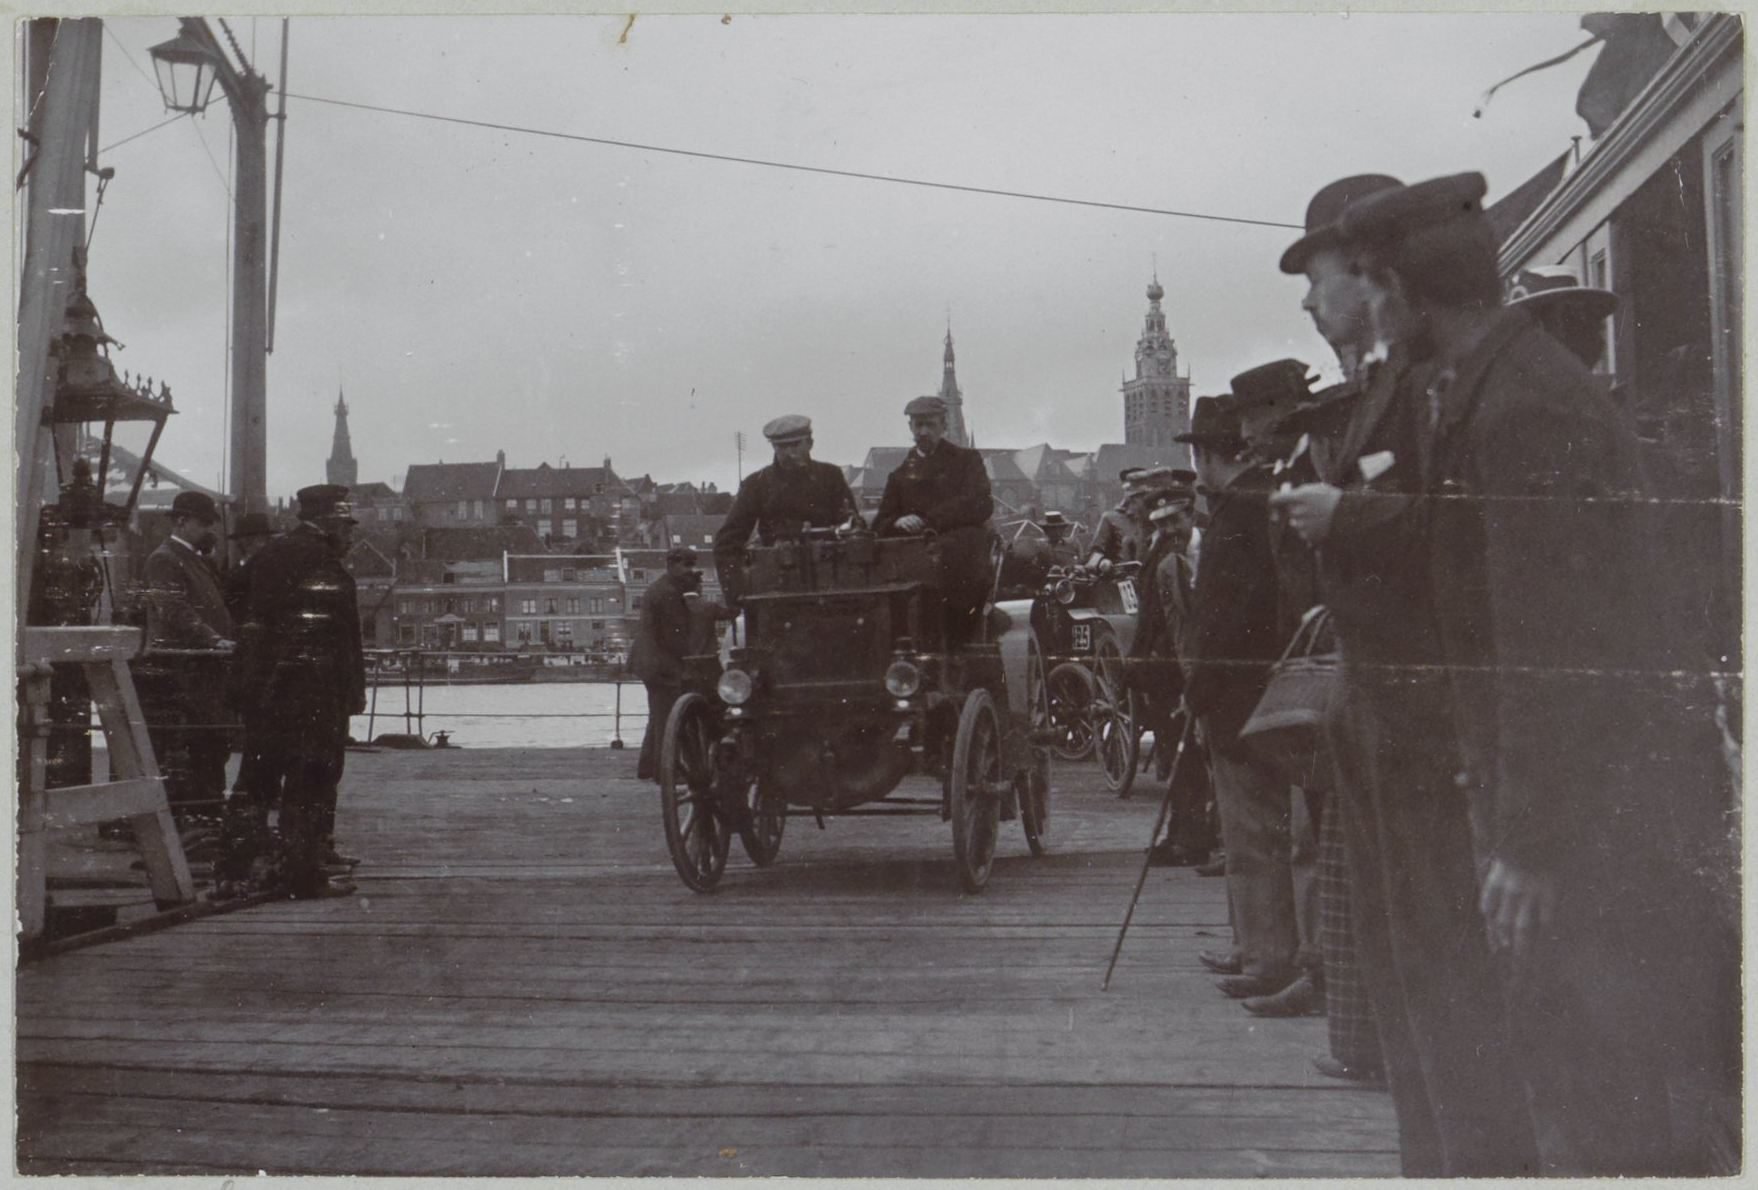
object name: photograph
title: Autocoureur Manchon, deelnemer aan de race Parijs-Amsterdam, in zijn automobiel te Nijmegen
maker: delizy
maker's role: manufacturer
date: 1807-1898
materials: paper, photographic support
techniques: collodion silver print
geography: nijmegen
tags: motorcar racing, automobile, nijmegen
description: Onderdeel van Fotoalbum van een Franse amateurfotograaf met opnames van uitstapjes in Frankrijk, Spanje, België, Luxemburg en Nederland, de eerste automobielen en autoraces.